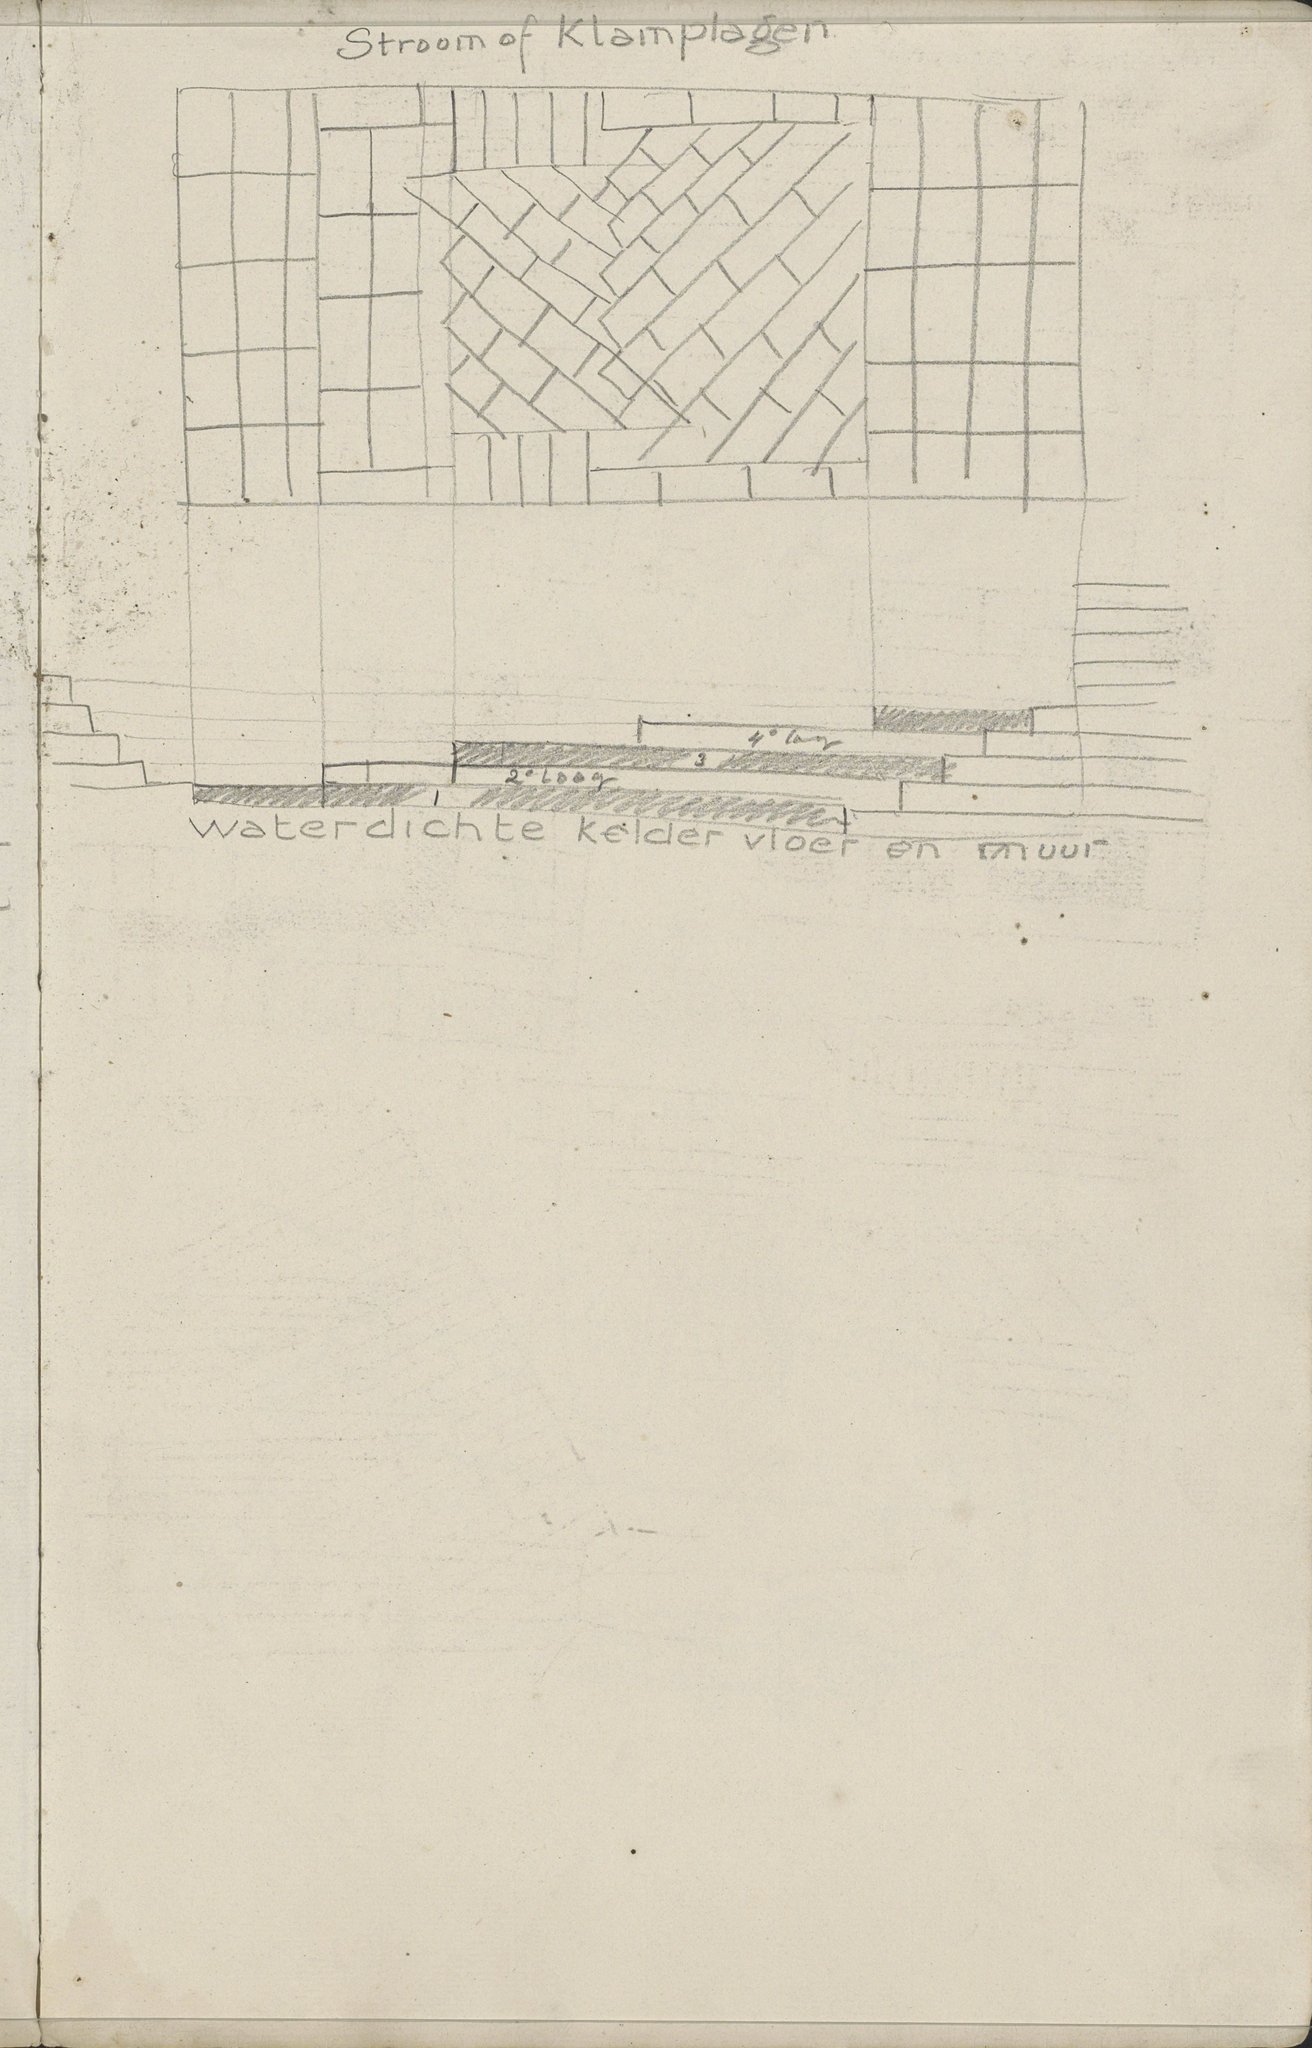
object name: sketchbook leaf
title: Metseltechniek voor een muur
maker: carel adolph lion cachet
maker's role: draughtsman, print maker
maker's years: 1864-1945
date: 1895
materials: paper, pencil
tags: tiles, bricks ~ building material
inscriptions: annotation: ‘Stroom of Klamplagen/ 4e laag/ 3/ 2e laag/ waterdichte kelder vloer en muur’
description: Blad 20 recto uit een schetsboek met 23 bladen.